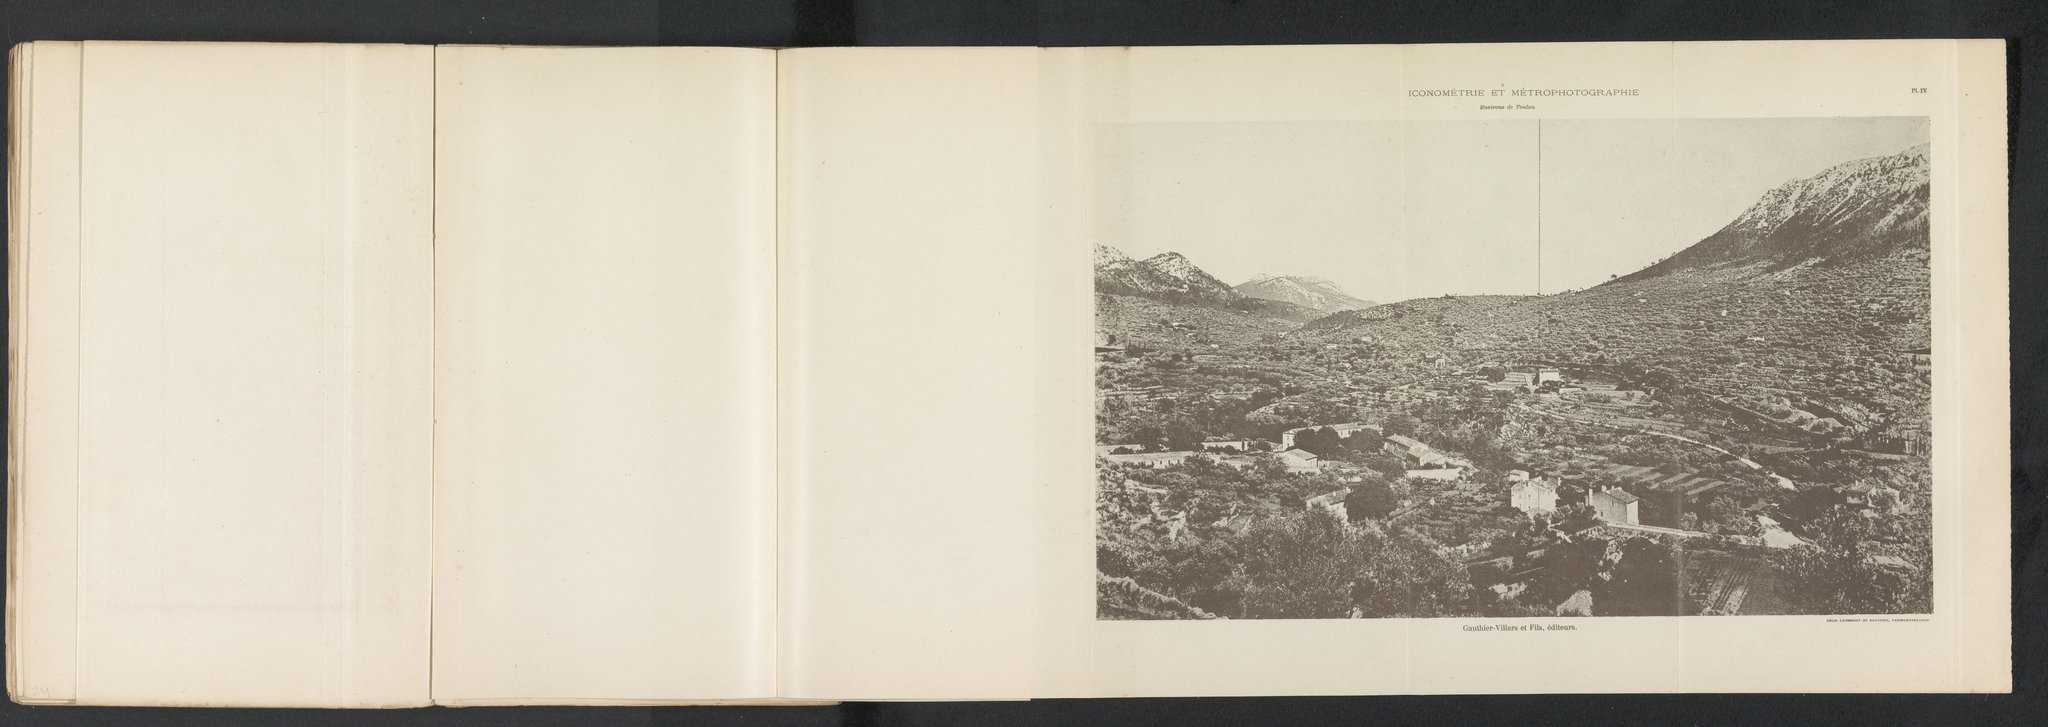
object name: page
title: Environs de Toulon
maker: Anonymous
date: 1883-1893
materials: paper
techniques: photograph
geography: toulon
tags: mountains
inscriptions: number: ‘Pl. IV.’